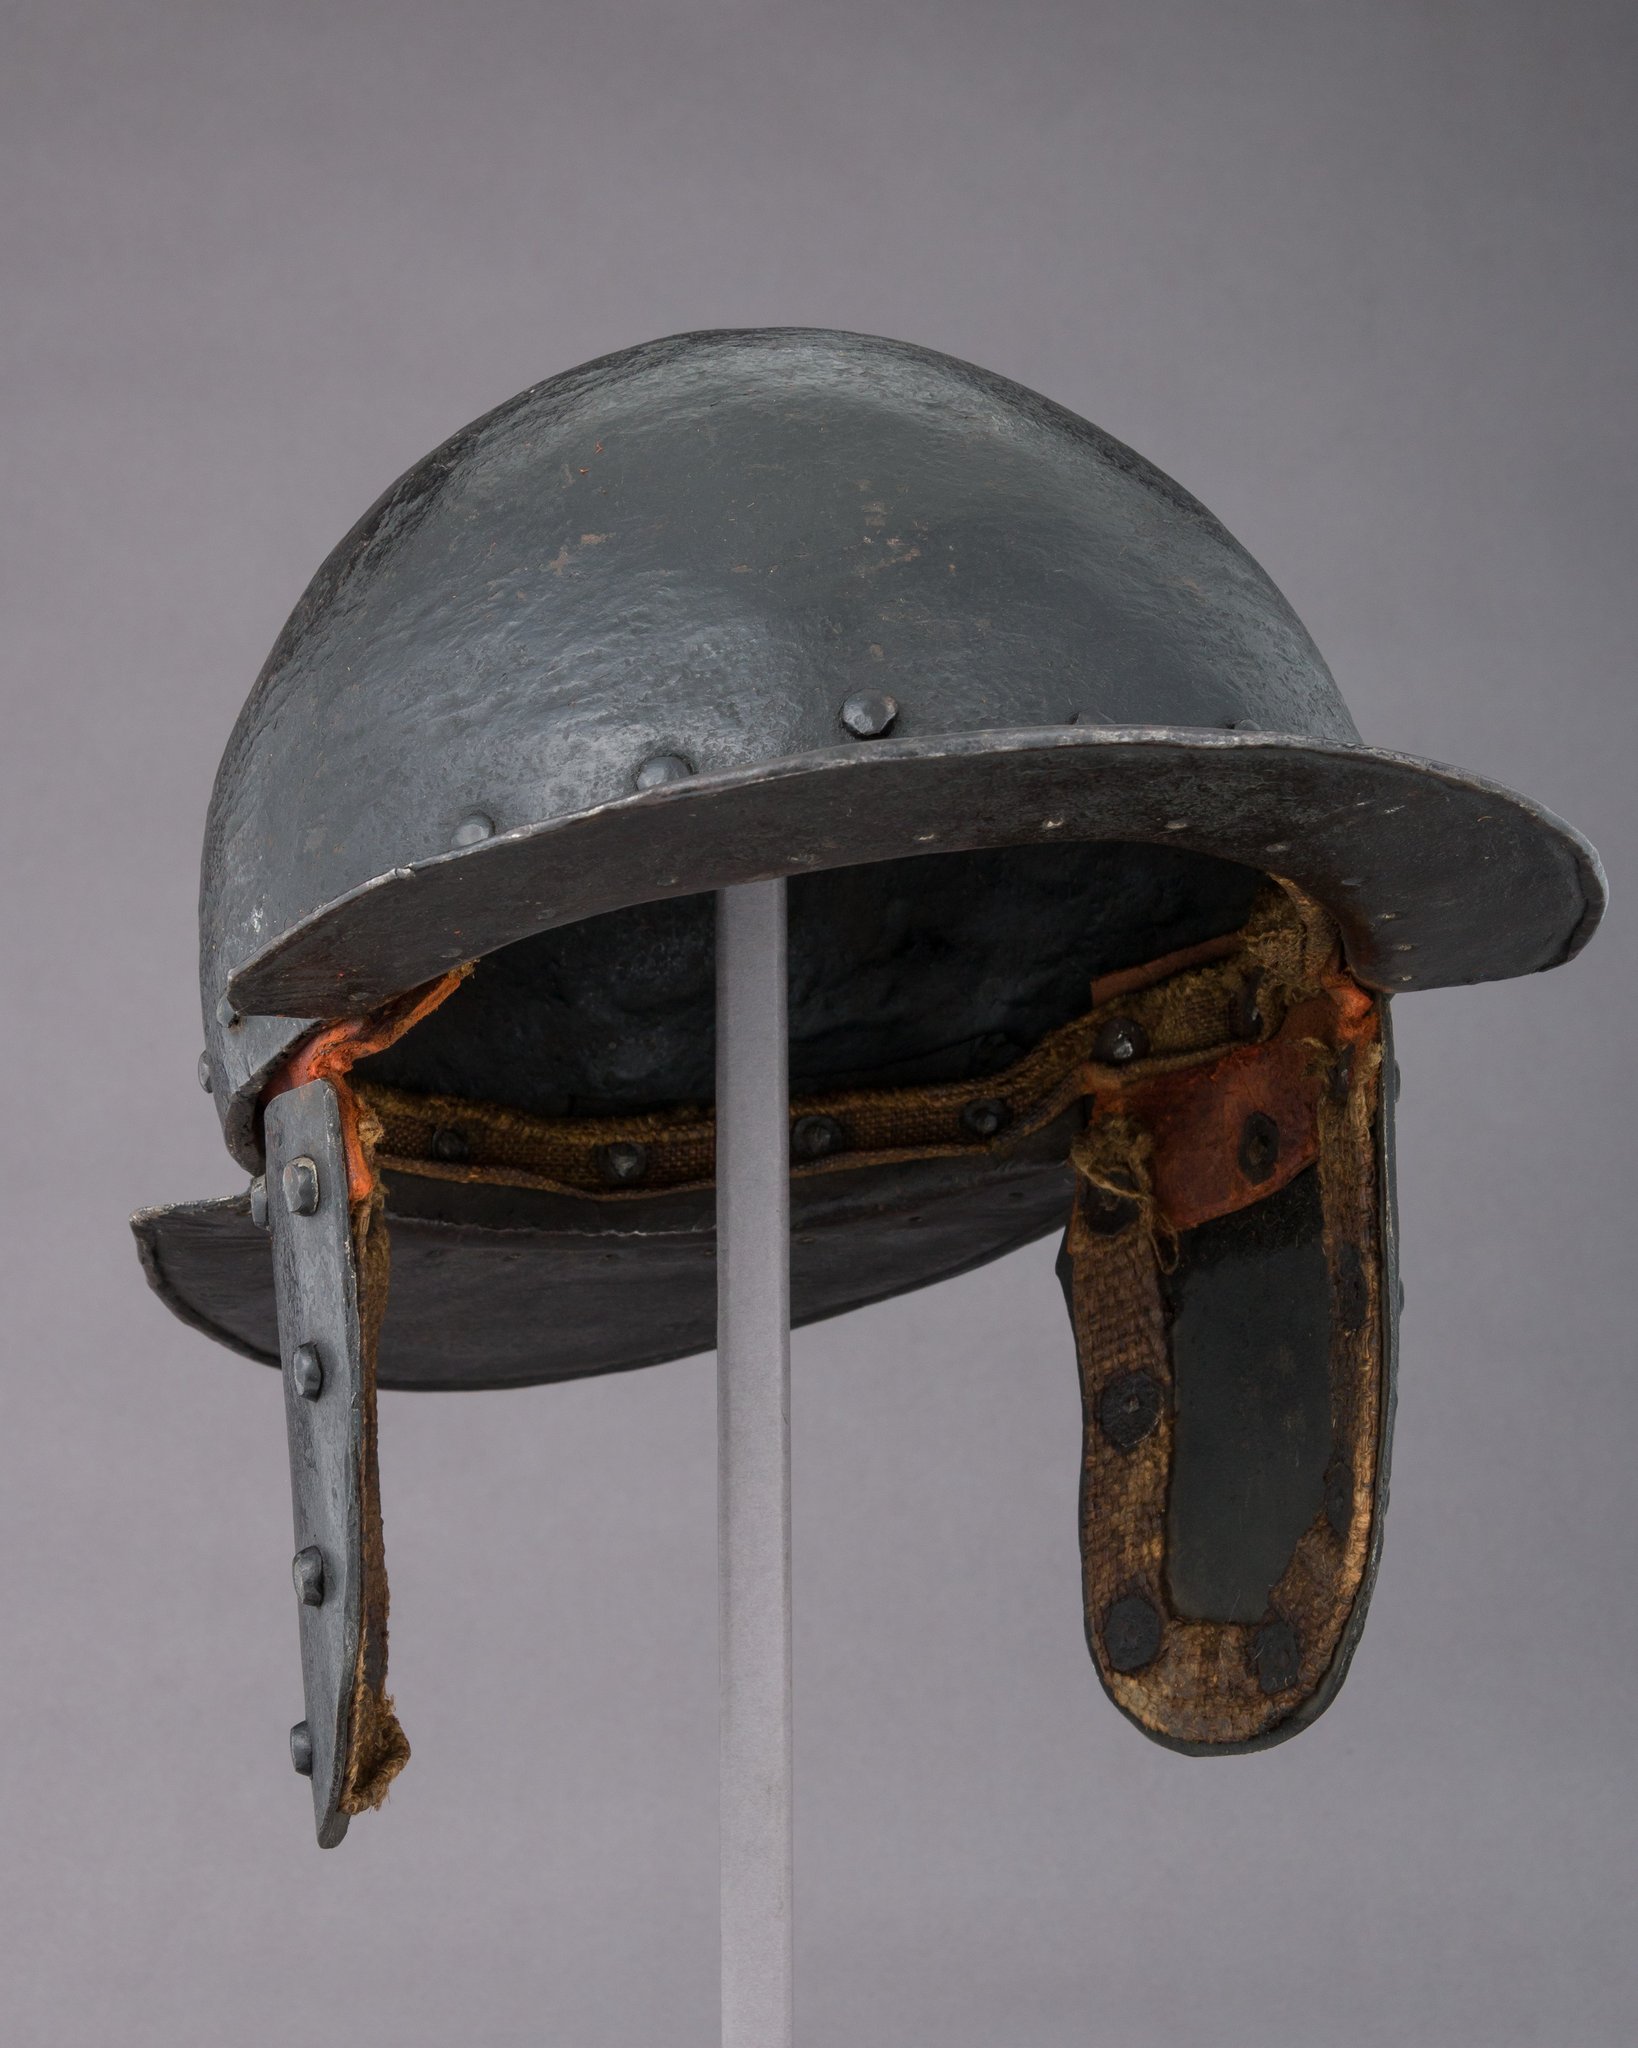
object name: siege helmet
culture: french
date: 1601-1800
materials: leather, steel, textile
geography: france